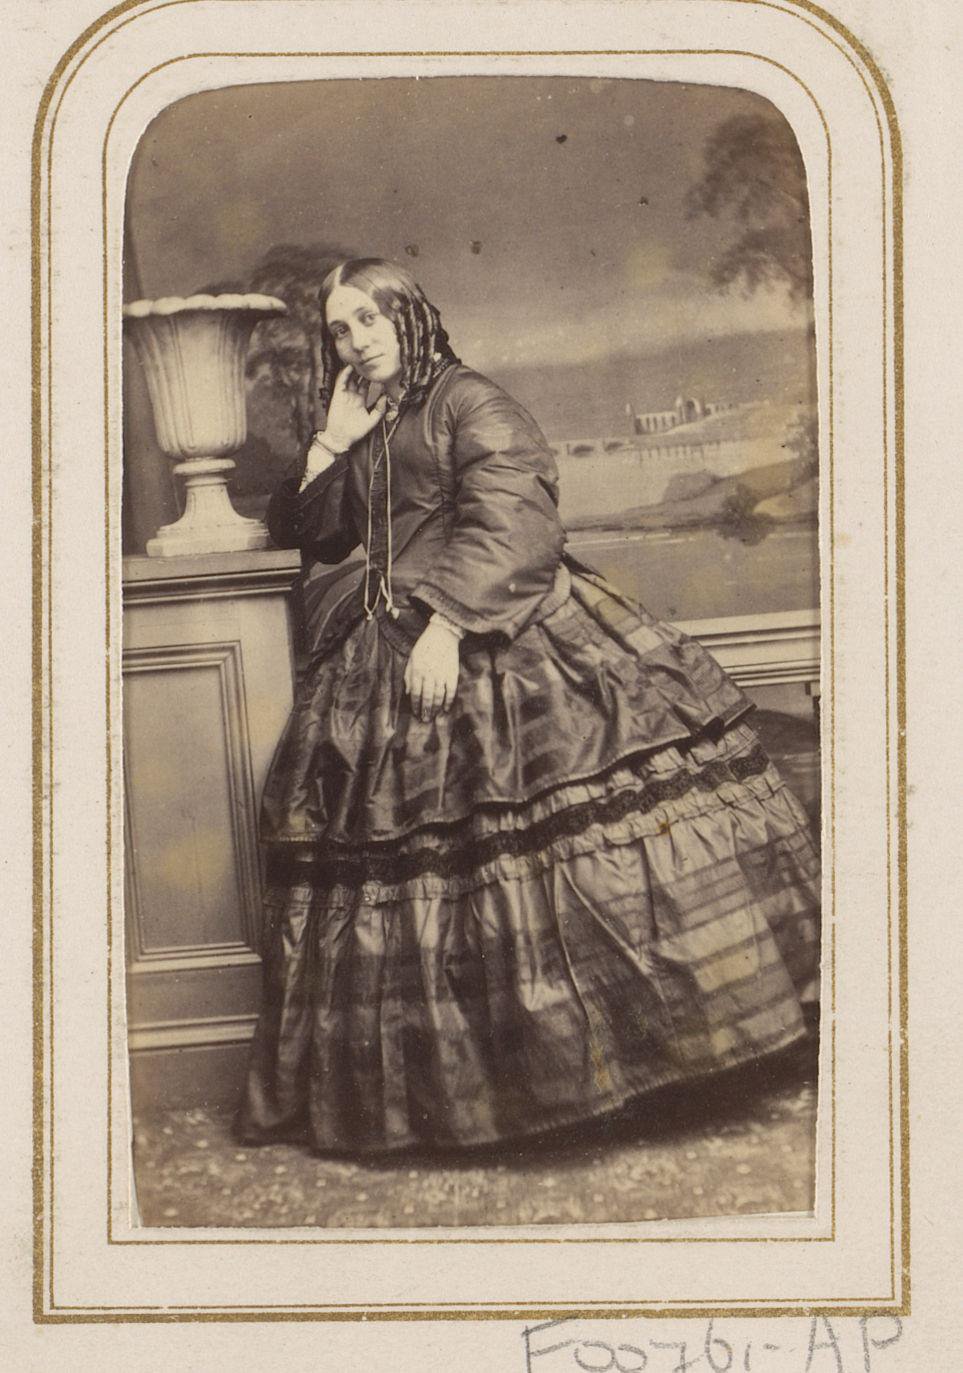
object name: album leaf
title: Portret van een staande vrouw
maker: s.j. wiseman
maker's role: fotograaf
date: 1855-1880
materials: cardboard, photographic support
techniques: albumen print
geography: southampton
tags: historical persons - bb - woman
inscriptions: inscription: ‘Photographed by/ S.J. Wiseman 9, Bernard St./ Southampton’